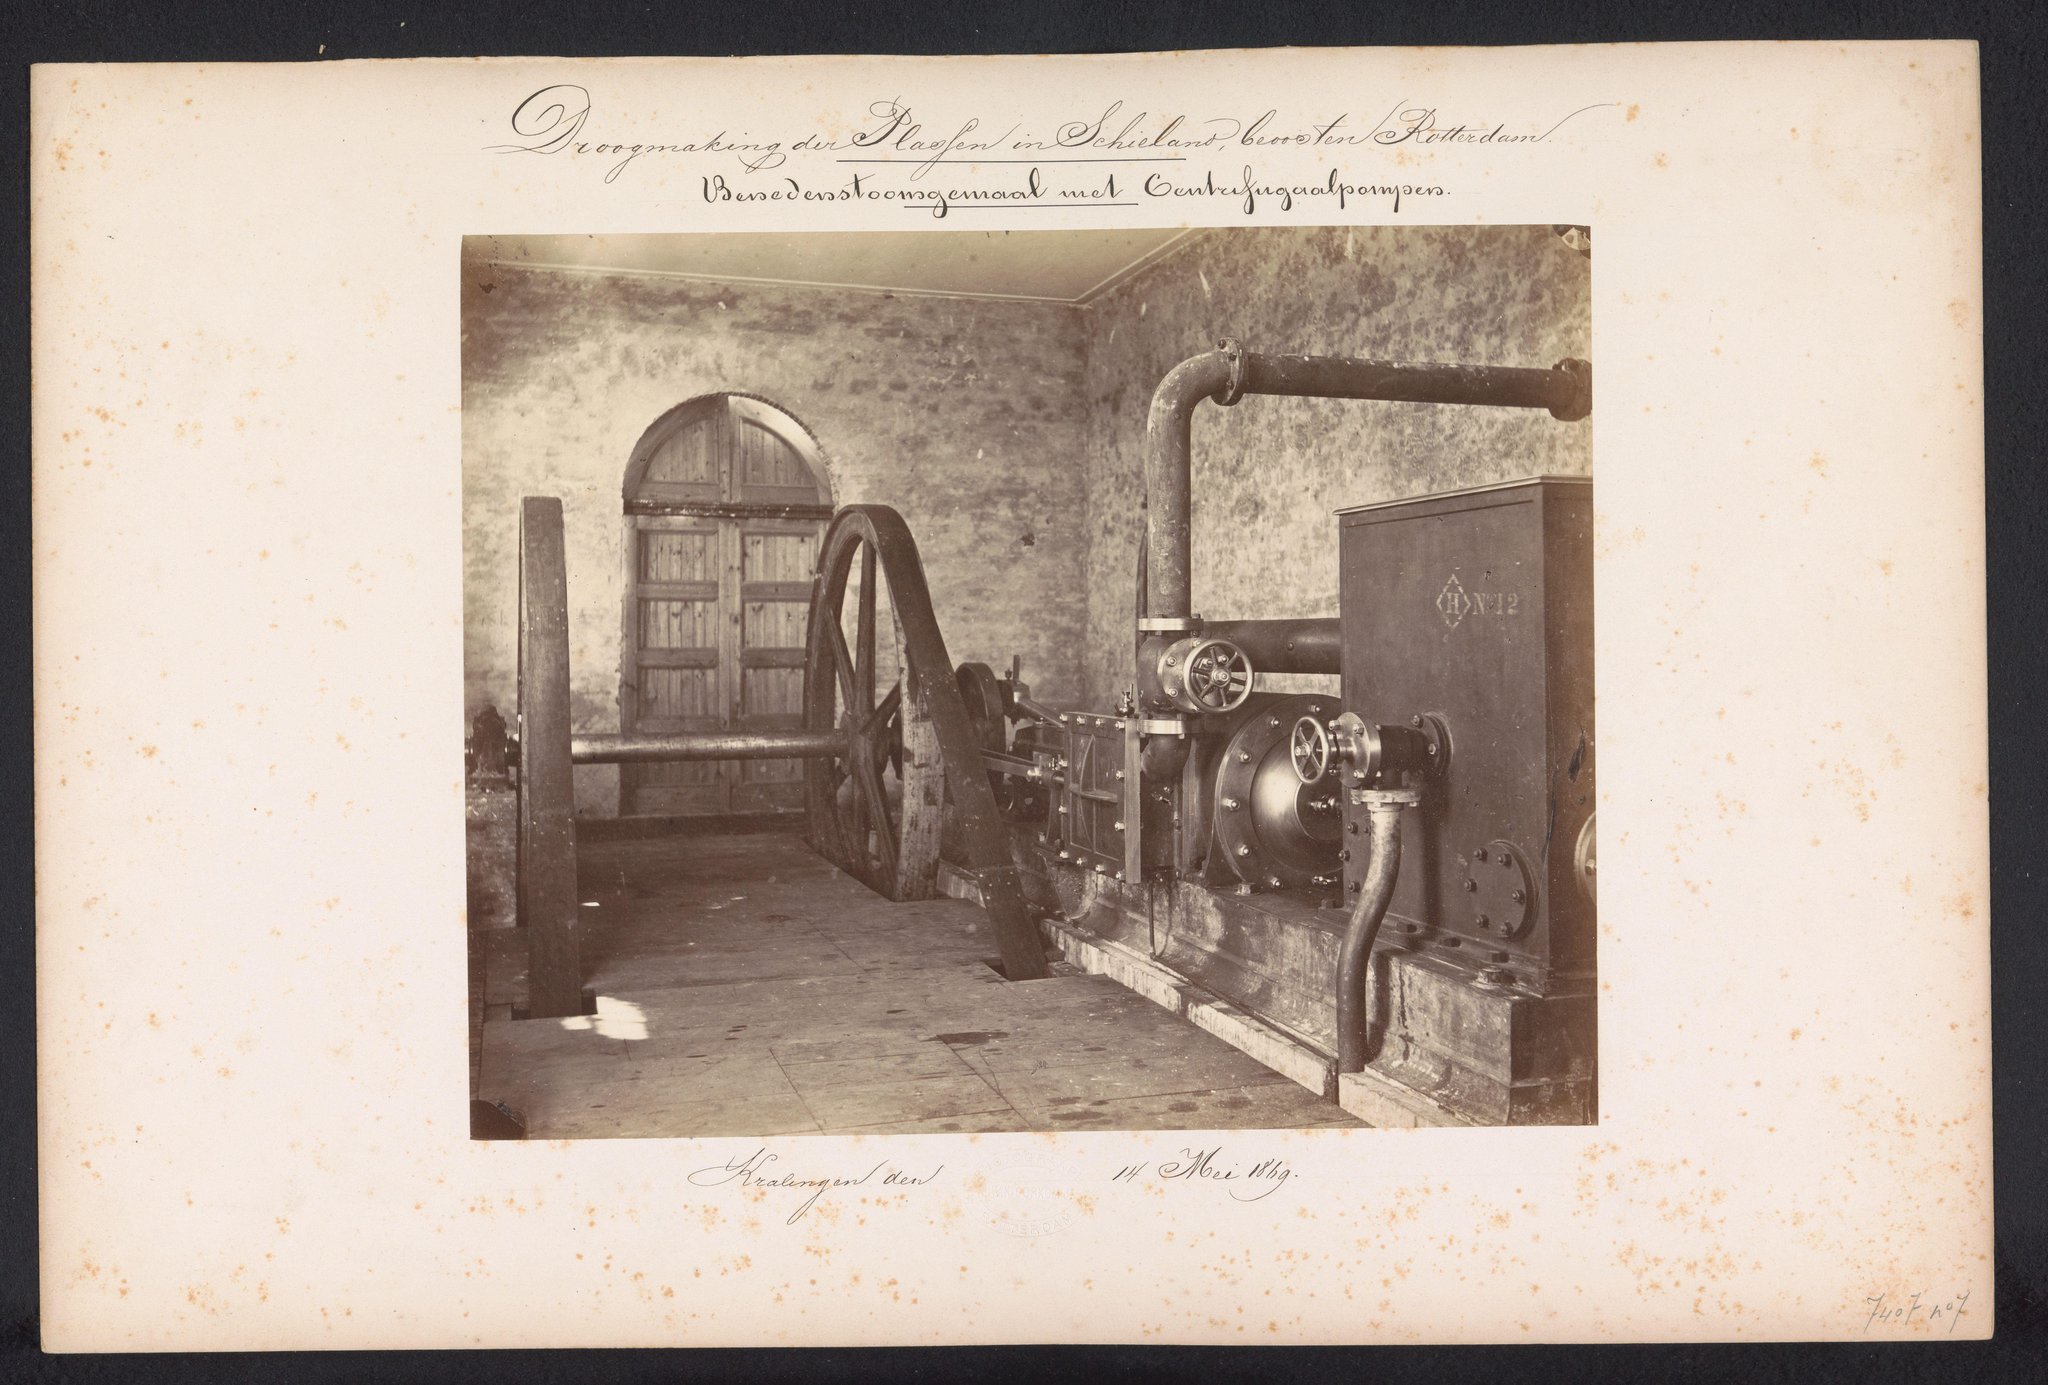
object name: photograph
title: Droogmaking der Plassen in Schieland beoosten Rotterdam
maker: jacobus van gorkom (jr.)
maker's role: print maker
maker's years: 1827-1880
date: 1869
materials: cardboard, photographic support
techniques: albumen print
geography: rotterdam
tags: draining for land reclamation, pumping installation, pumping-engine (~ polder)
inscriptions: date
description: Stoomgemaal te Kralingen op 14 mei 1869. Onderdeel van een serie van tien foto's van de droogmaking in 1867-1869 van de plassen in Schieland ten oosten van Rotterdam.